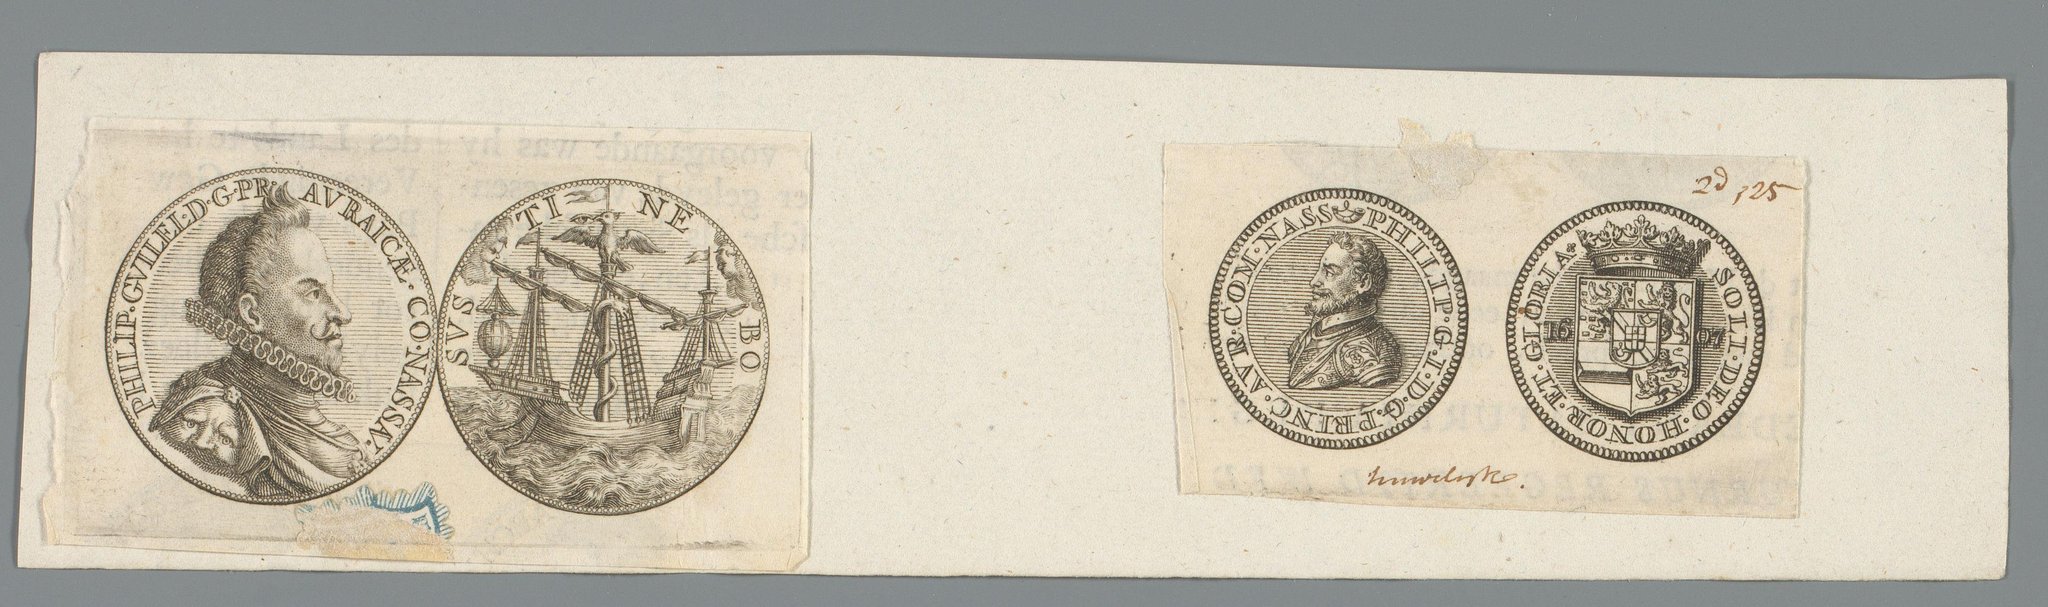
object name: book illustration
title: Voor- en achterzijden van twee penningen met daarop het portret van Filips Willem van Oranje, een personificatie en zijn wapenschild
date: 1723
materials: paper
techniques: etching, letterpress printing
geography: the hague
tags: buren, bruges, filips willem (prins van oranje), coat of arms (symbol of sovereignty), prince, historical persons, coin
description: Eerste prent uit: Loon, Gerard van. Beschryving der Nederlandsche Historipenningen: (...). Den Haag: Christiaan van Lom et al., 1723, dl. 1, p. 472. Tweede prent uit: Loon, Gerard van. Beschryving der Nederlandsche Historipenningen: (...). Den Haag: Christiaan van Lom et al., 1726, dl. 2, p. 25.